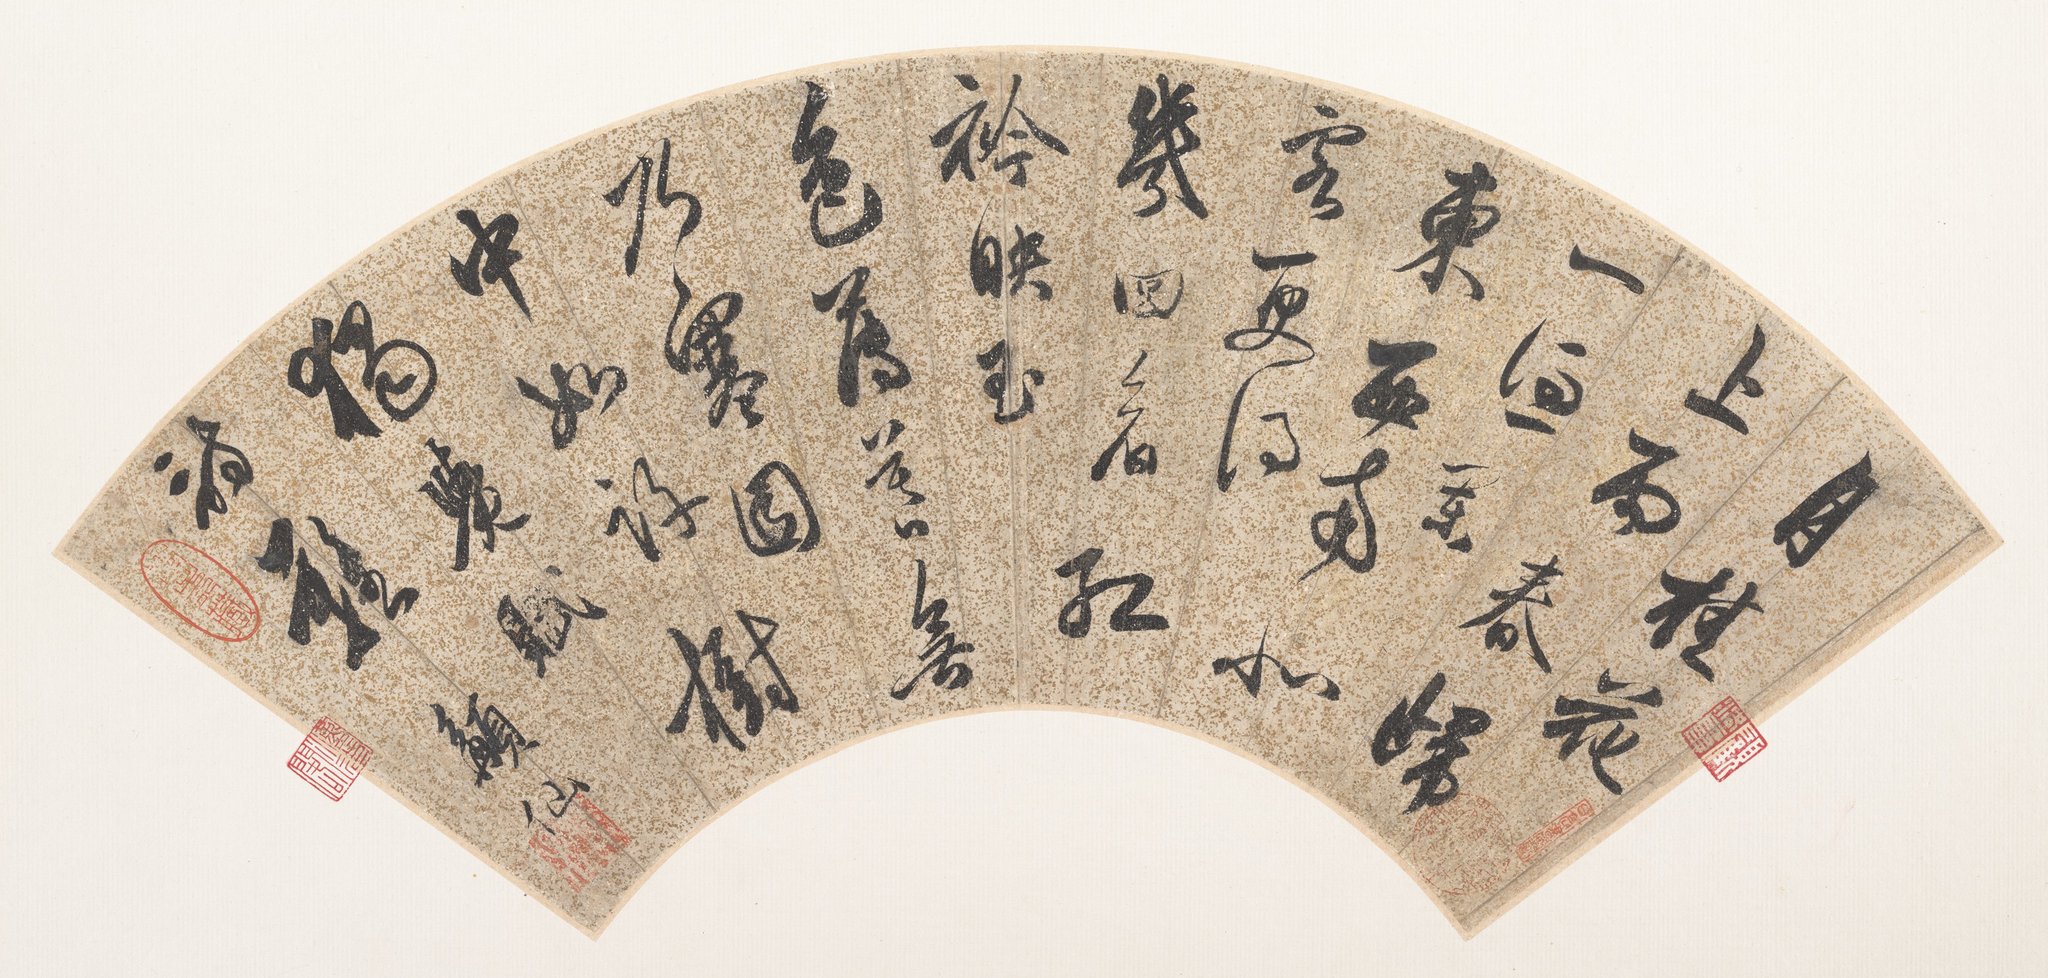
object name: folding fan mounted a an album leaf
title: Rain on Laurel Blossoms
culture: chinese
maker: xu lin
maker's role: artist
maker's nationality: chinese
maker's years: 1462-1548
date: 1462-1548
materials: gold, ink, paper